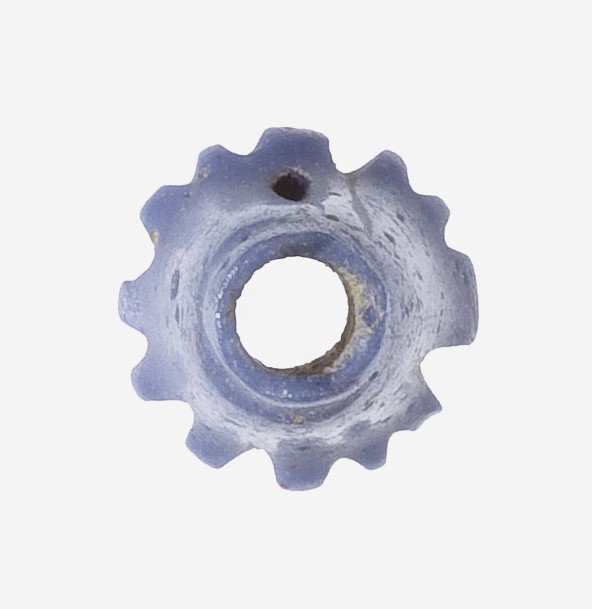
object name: pendant, cornflower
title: Pendant: Petals of Cornflower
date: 1390-1352 BCE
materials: faience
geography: egypt